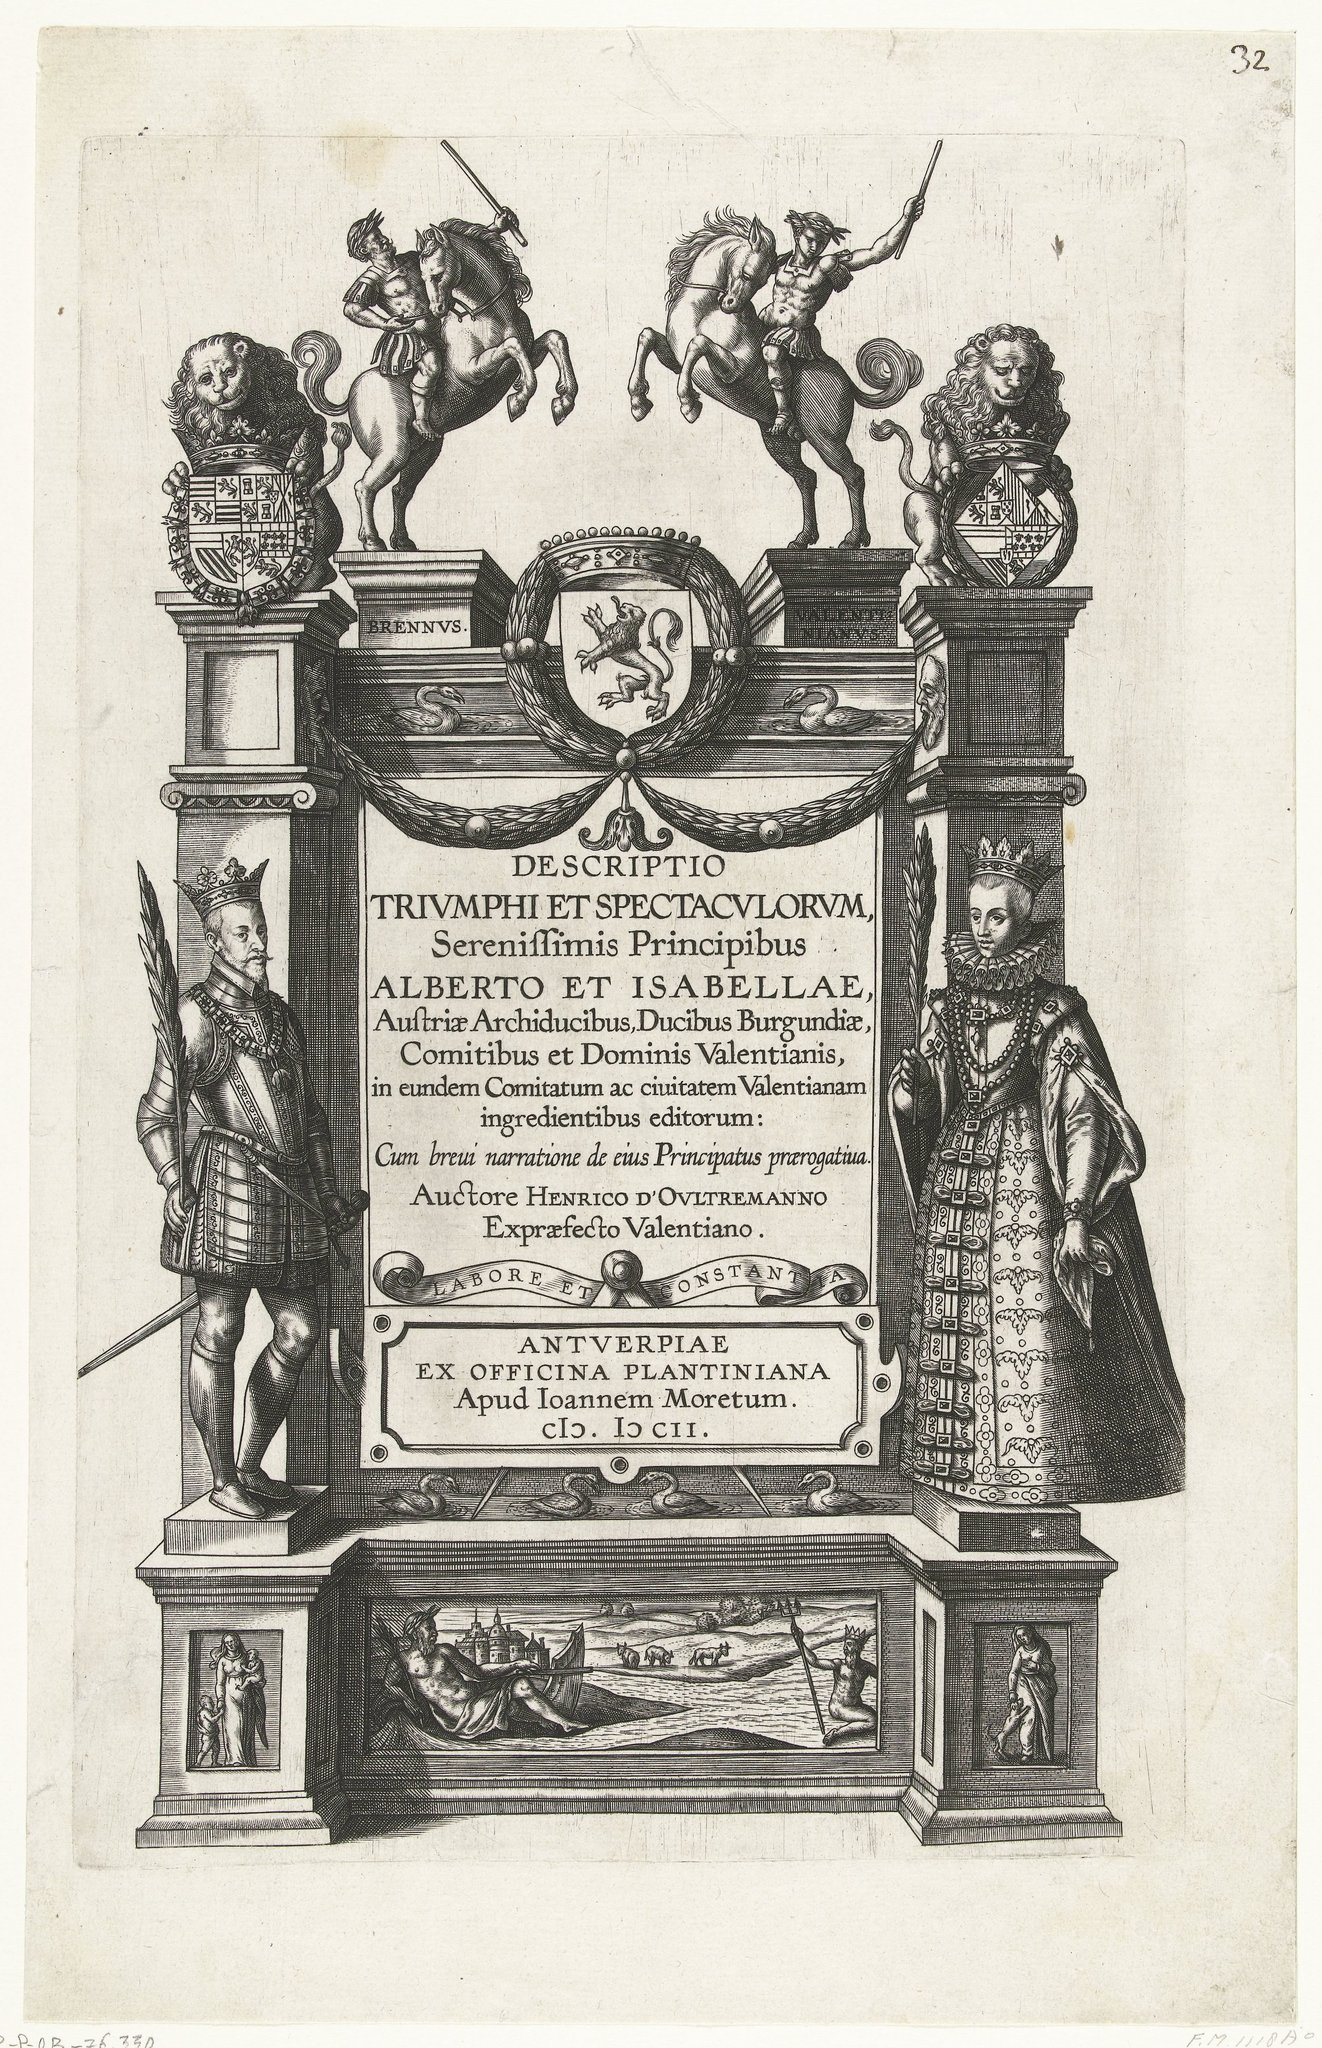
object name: titelprent, frontispice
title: Descriptio triumphi et spectaculorum, serenissimis principibus Alberto et Isabellae, Austriae Archiducibis (...) ac civitatem Valentiannam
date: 1600-1602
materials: paper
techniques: engraving, etching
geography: antwerp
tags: infante van spanje isabella clara eugenia, brussels, albrecht aartshertog van oostenrijk, title-page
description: Los exemplaar van de titelprent voor Descriptio triumphi et spectaculorum van H. d'Outreman, de beschrijving van de intocht van Albrecht en Isabella te Valenciennes, december 1599. Titelprent met de Latijnse titel in een architecturale omlijsting met aan weerszijden staande de aartshertog Albrecht van Oostenrijk en Isabella Clara Eugenia, infante van Spanje. Bovenaan twee Romeinse ruiters, Brennus en Valentinianus. Onderdeel van de complete beschrijving van de intochten van het paar te Brussel, Antwerpen, Gent en Valenciennes, 1599.